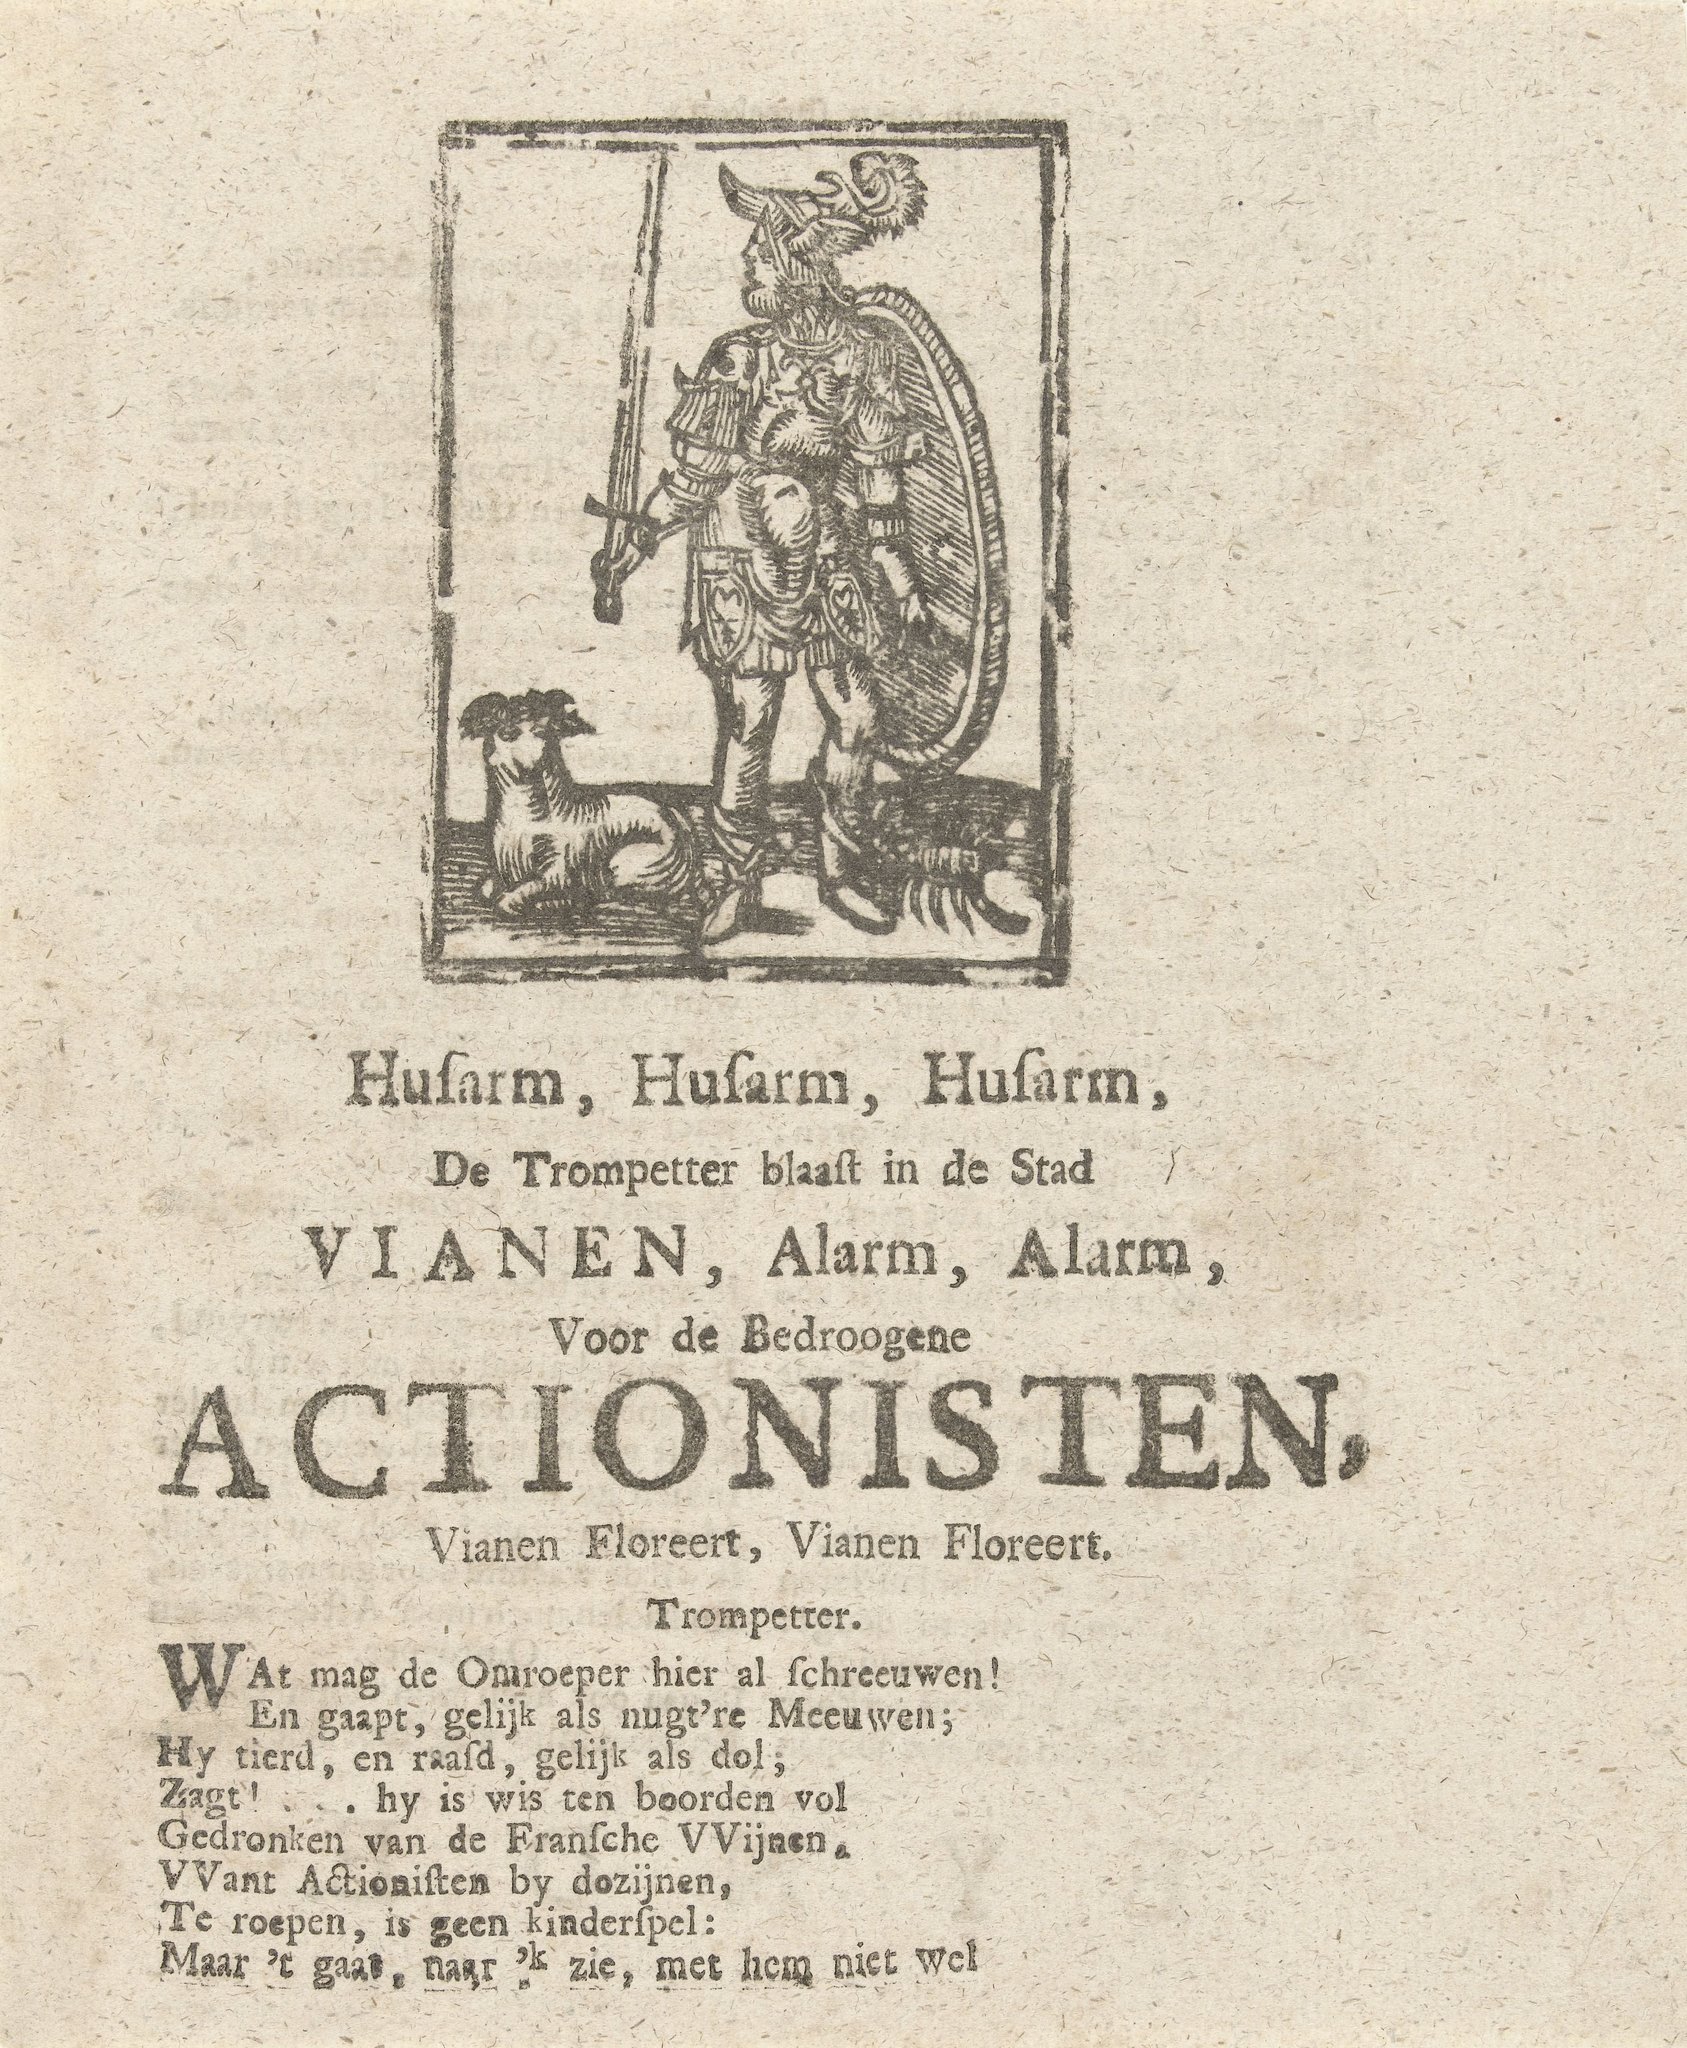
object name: print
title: Husarm, Husarm, Husarm, De trompetter blaast in de Stad Vianen, Alarm, Alarm, Voor de Bedroogene Actionisten, Vianen Floreert, Vianen Floreert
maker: Anonymous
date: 1720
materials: paper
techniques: letterpress printing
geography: northern netherlands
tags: vianen, windhandel van 1720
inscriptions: collector's mark: Lugt 2228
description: Pamflet getiteld: Husarm, Husarm, Husarm, De trompetter blaast in de Stad Vianen, Alarm, Alarm, Voor de Bedroogene Actionisten. Blad aan beide zijden bedrukt met een vers waarin de spot wordt gedreven met de actionisten en de windhandel in Vianen in het jaar 1720. Op de voorzijde een voorstelling van een krijger met zwaard, hond en kreeft. Behoort tot de groep van bijprenten toegevoegd aan de serie Tafereel der Dwaasheid met spotprenten op de Windhandel of Actiehandel van 1720.